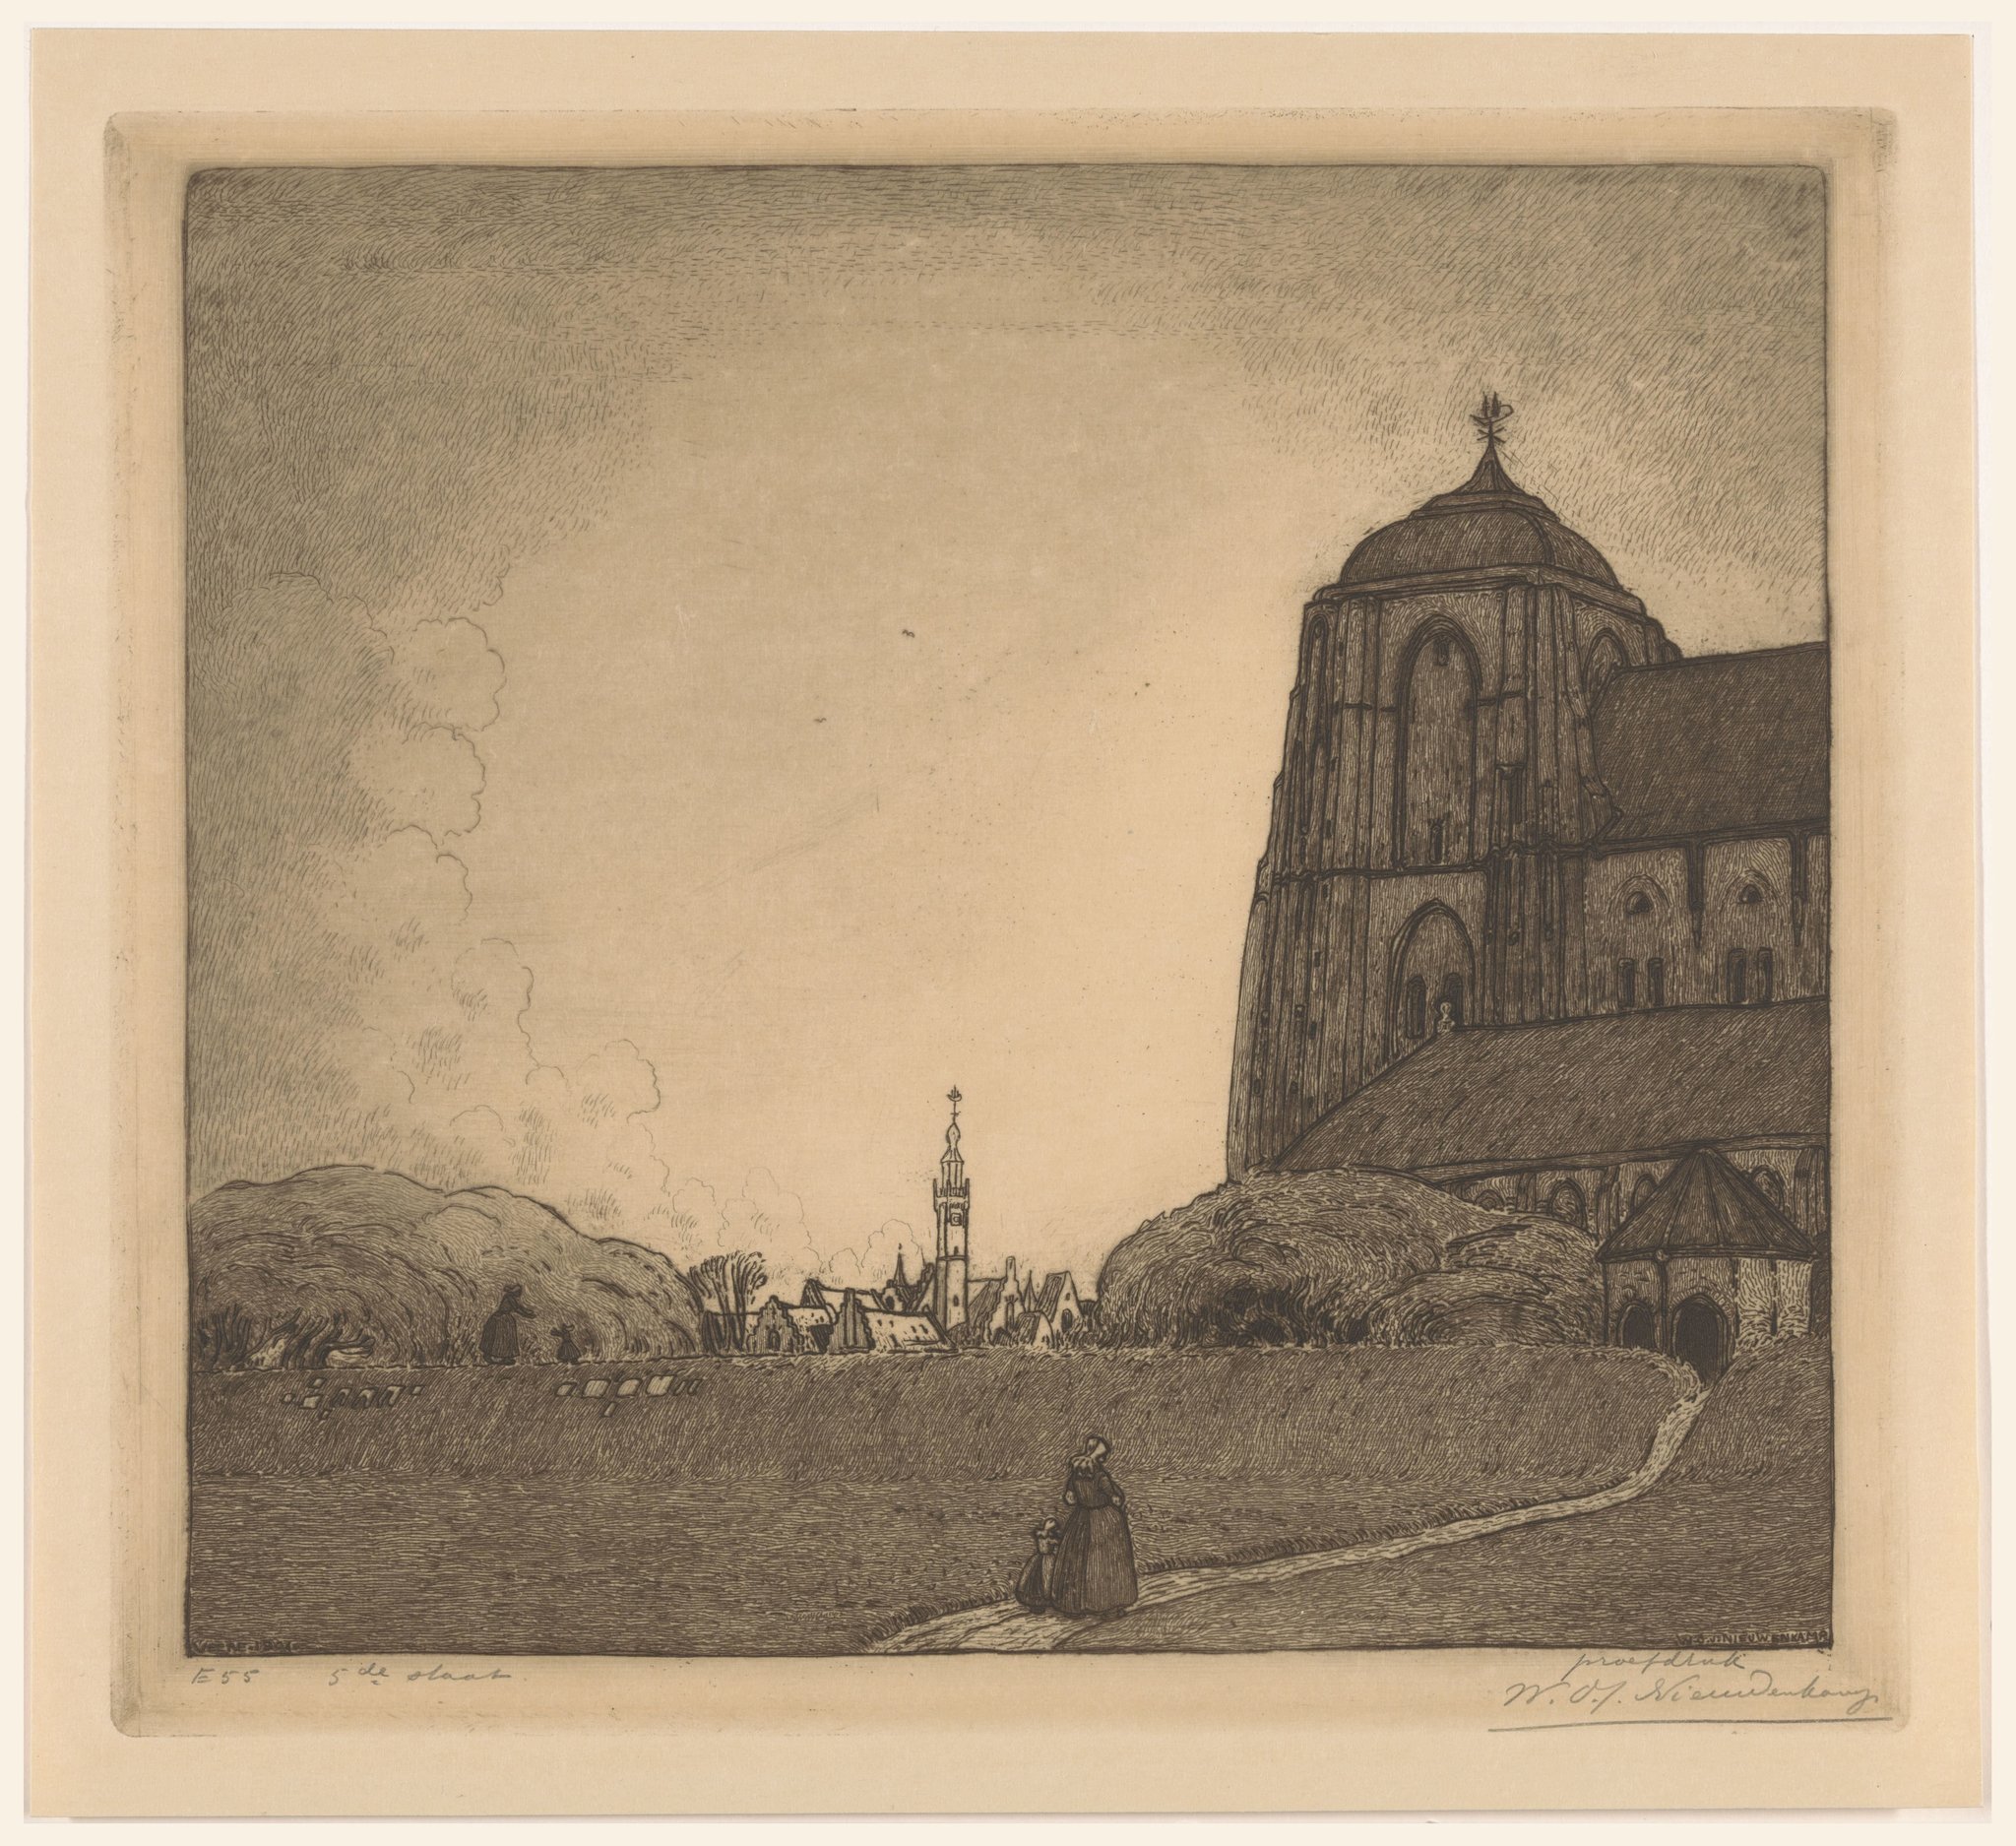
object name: print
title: Gezicht op Veere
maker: wijnand otto jan nieuwenkamp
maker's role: draughtsman, print maker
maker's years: 1874-1950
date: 1901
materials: paper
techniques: etching, intaglio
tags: city-view, and landscape with man-made constructions, church (exterior), road, path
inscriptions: collector's mark: Lugt 2233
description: Rechts een pad dat leidt naar de Grote Kerk. Links een zicht op de stad, met onder meer de toren van het stadhuis.